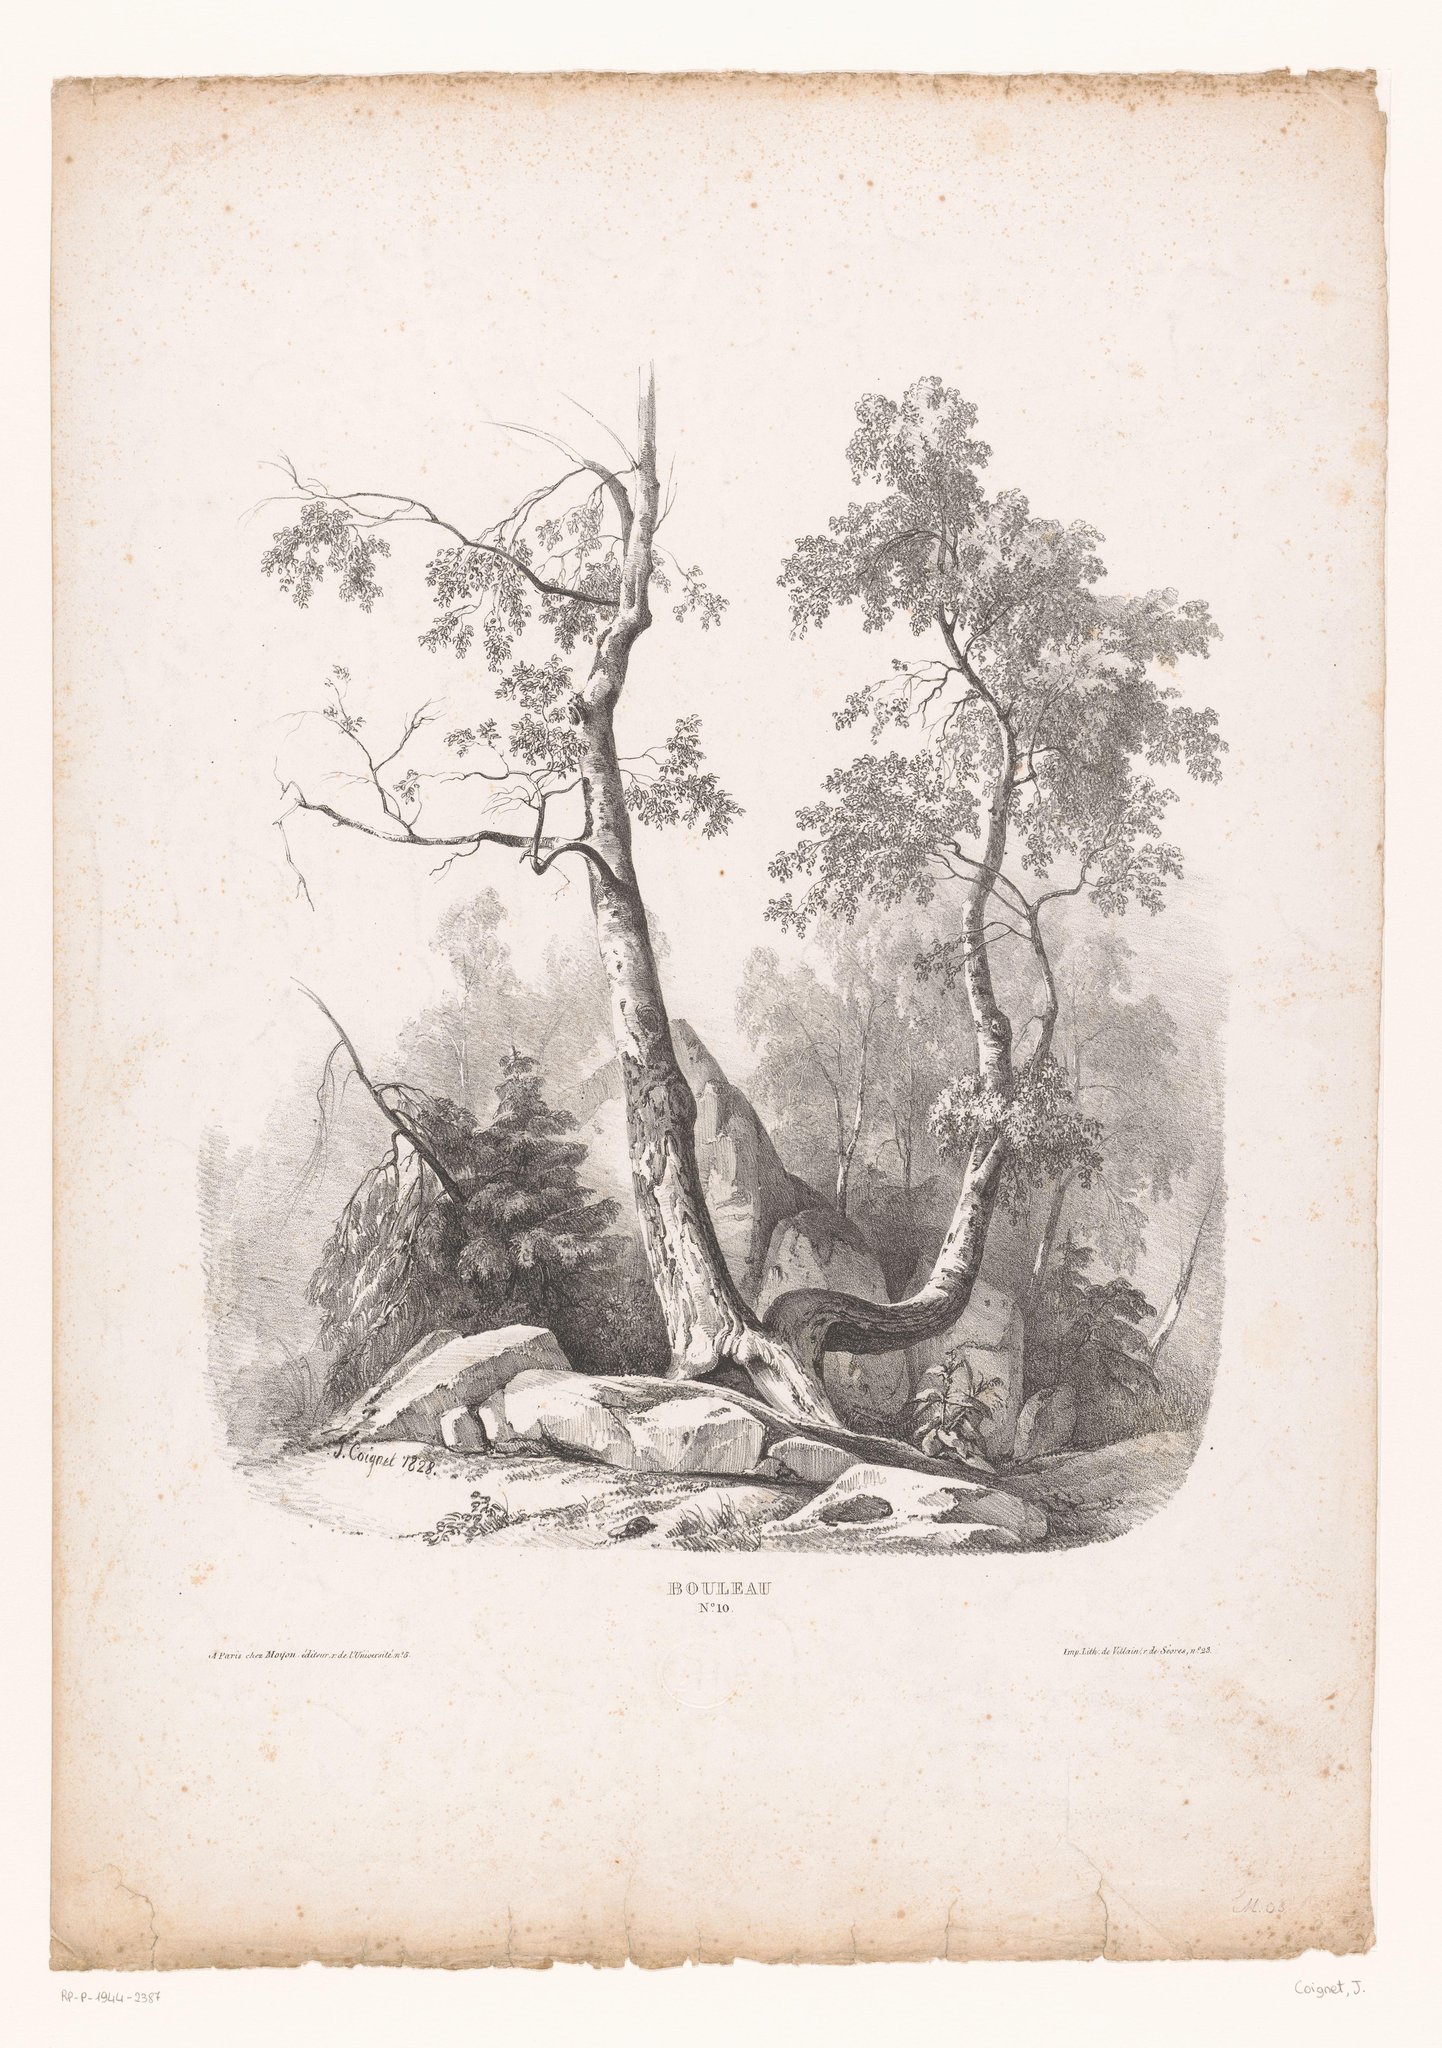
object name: print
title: Bouleau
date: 1828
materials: paper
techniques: lithograph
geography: paris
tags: landscapes, trees: birch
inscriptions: collector's mark: Lugt 2228, inscription: ‘M. 03’, check stamp: Lugt 4590